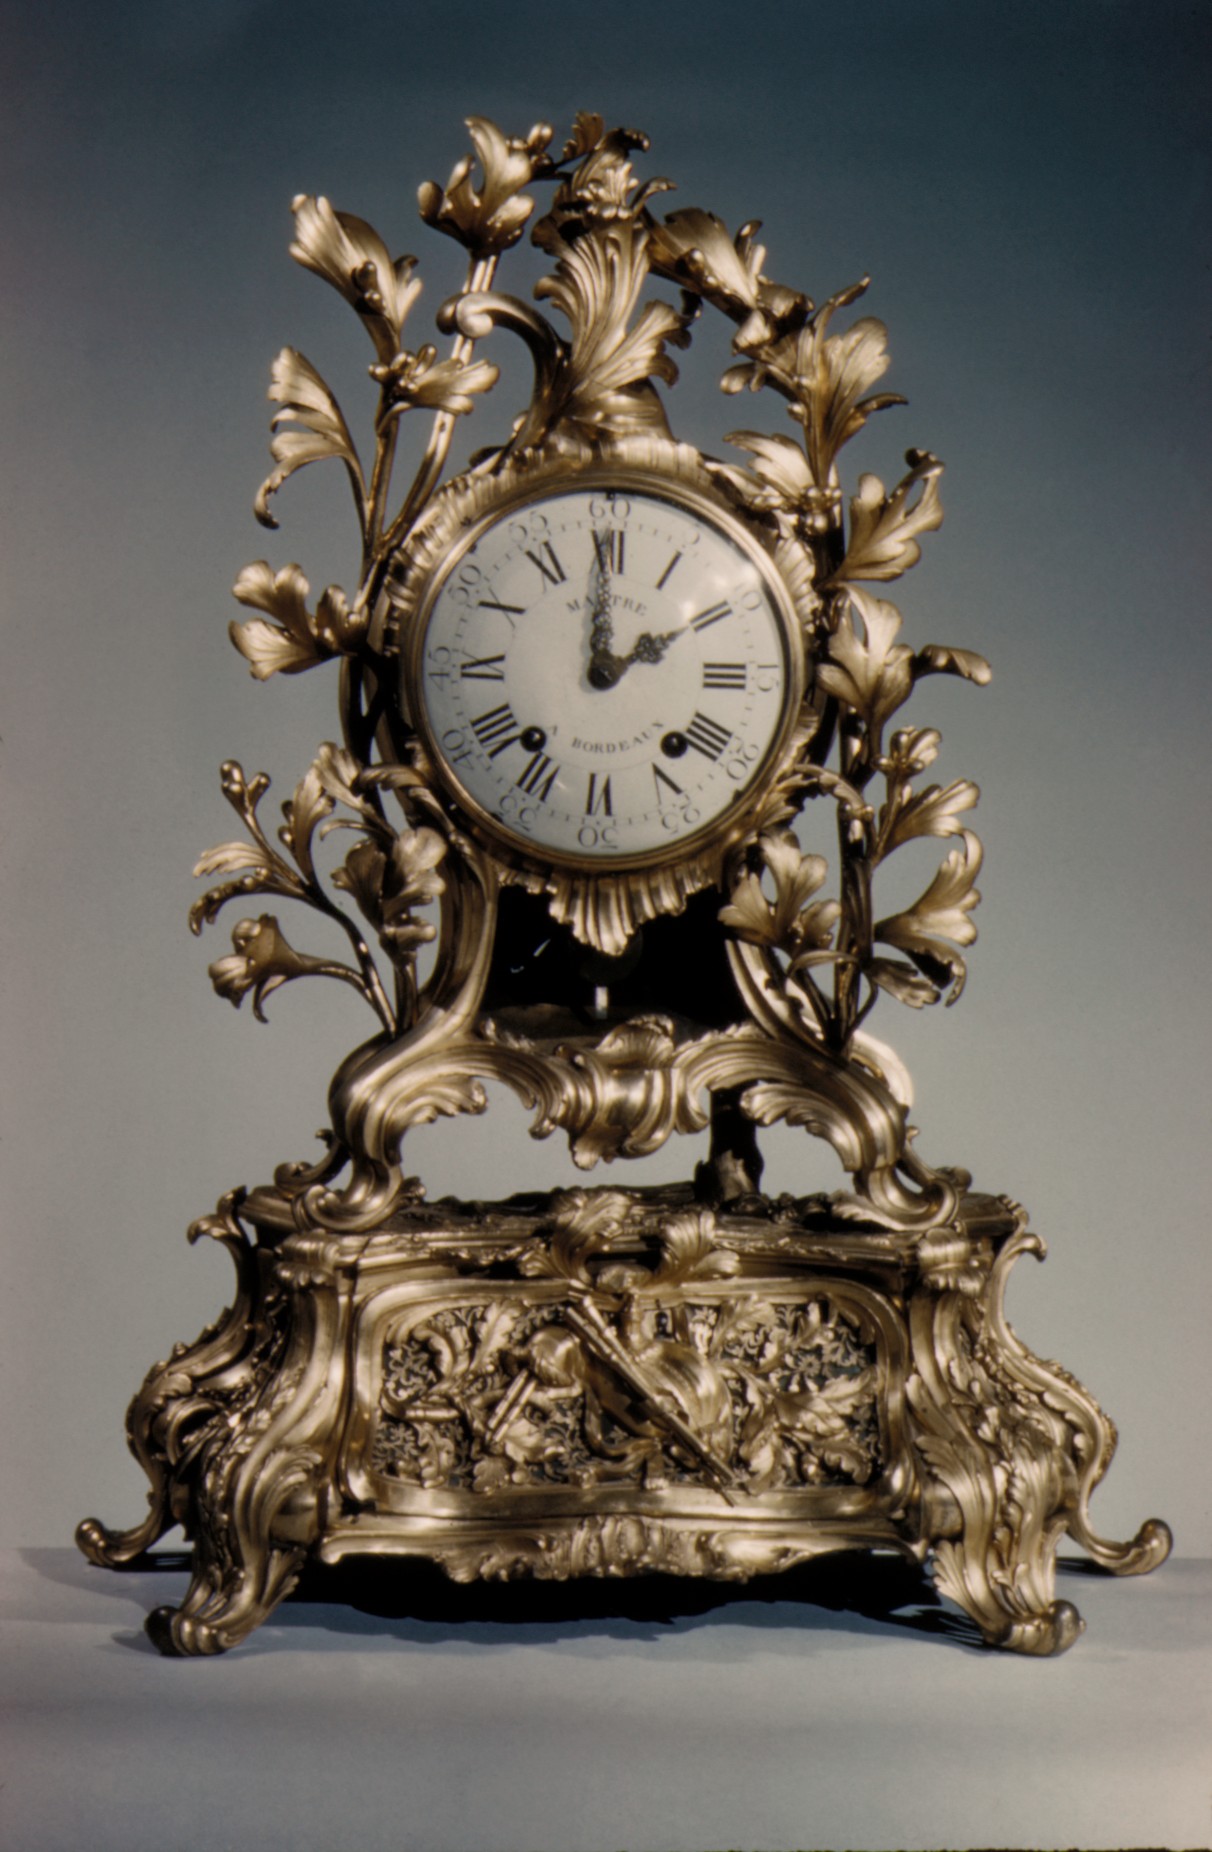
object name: musical mantel clock pendule avec boîte à musique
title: Musical mantel clock (Pendule avec boîte à musique)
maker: jean baptiste martre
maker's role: maker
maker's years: 1734-1834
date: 1770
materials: gilt bronze